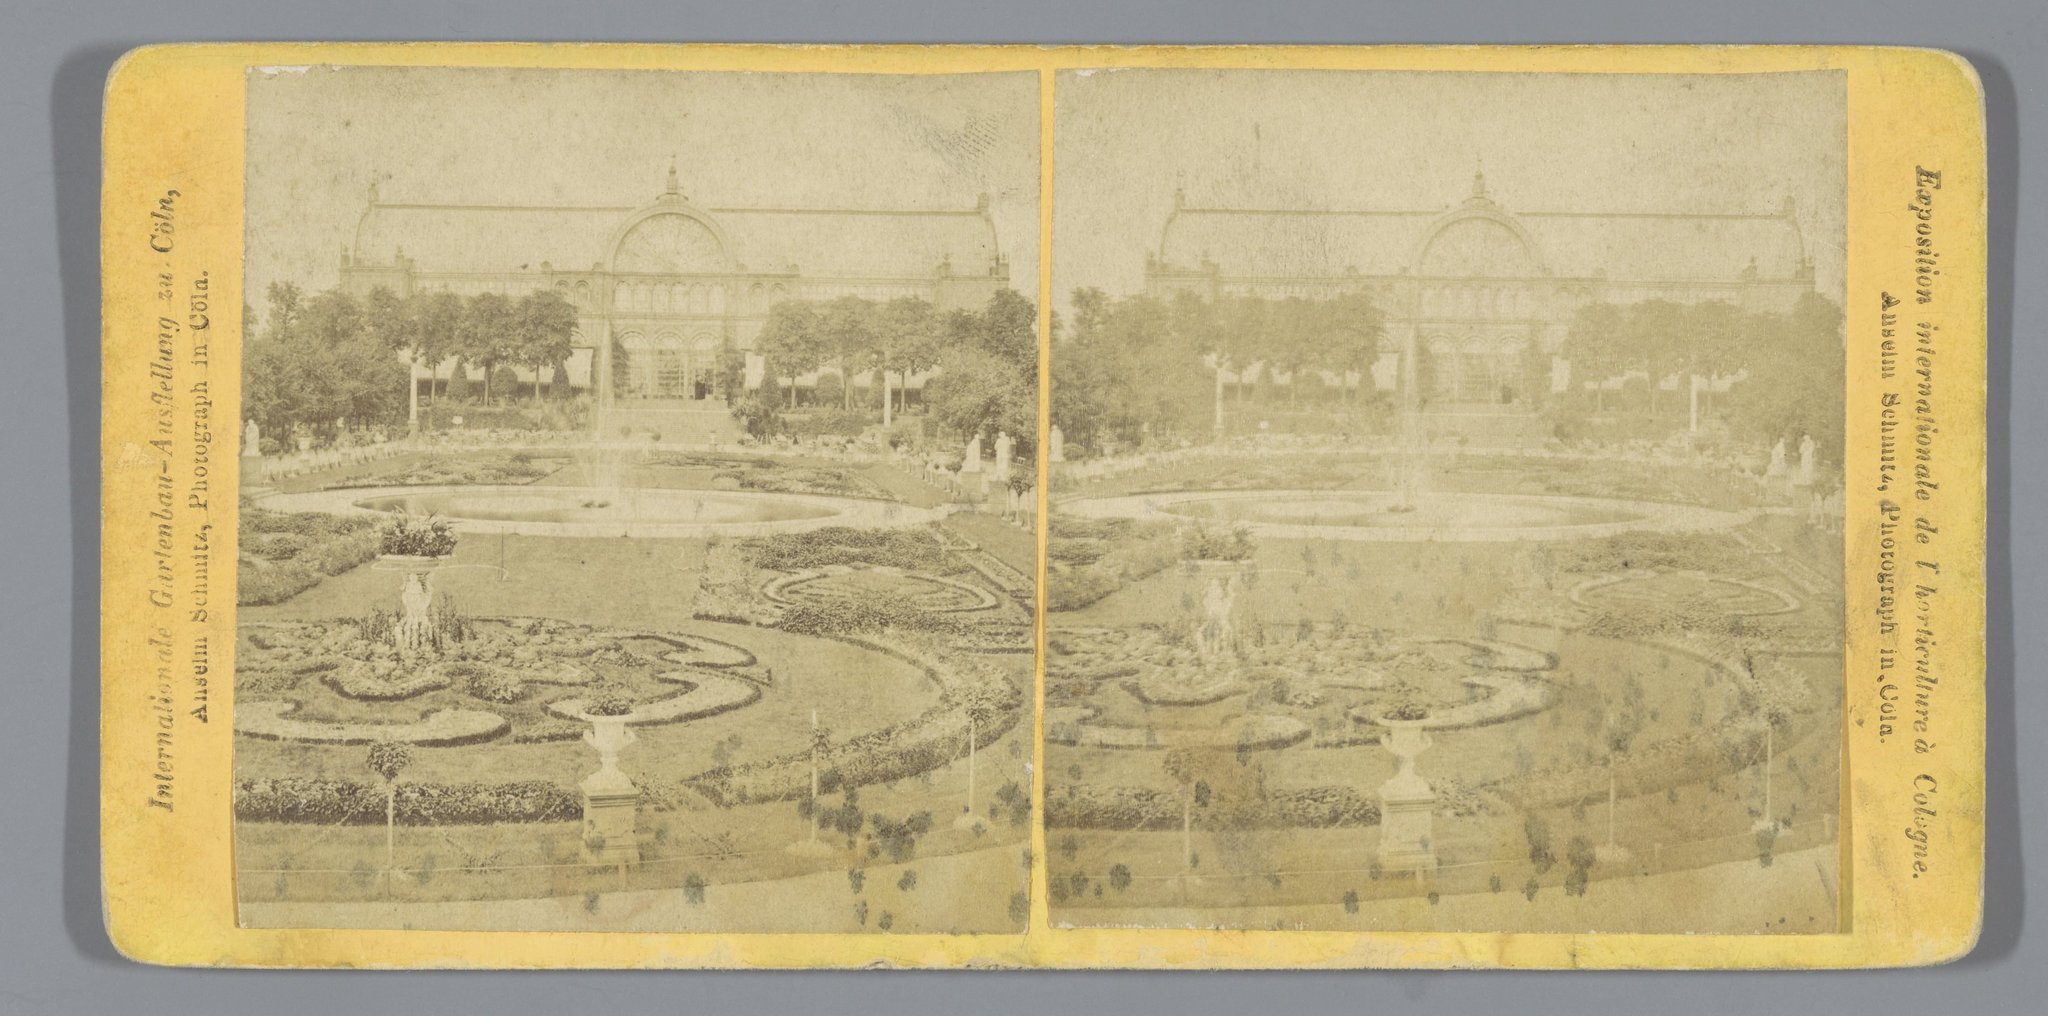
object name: stereograph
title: Internationale Gartenbau-Ausstellung zu Cöln / Exposition internationale de l'horticulture à Cologne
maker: anselm schmitz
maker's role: publisher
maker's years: 1831-1903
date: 1875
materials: cardboard, paper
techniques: albumen print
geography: cologne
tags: botanic garden, 'hortus botanicus', cologne